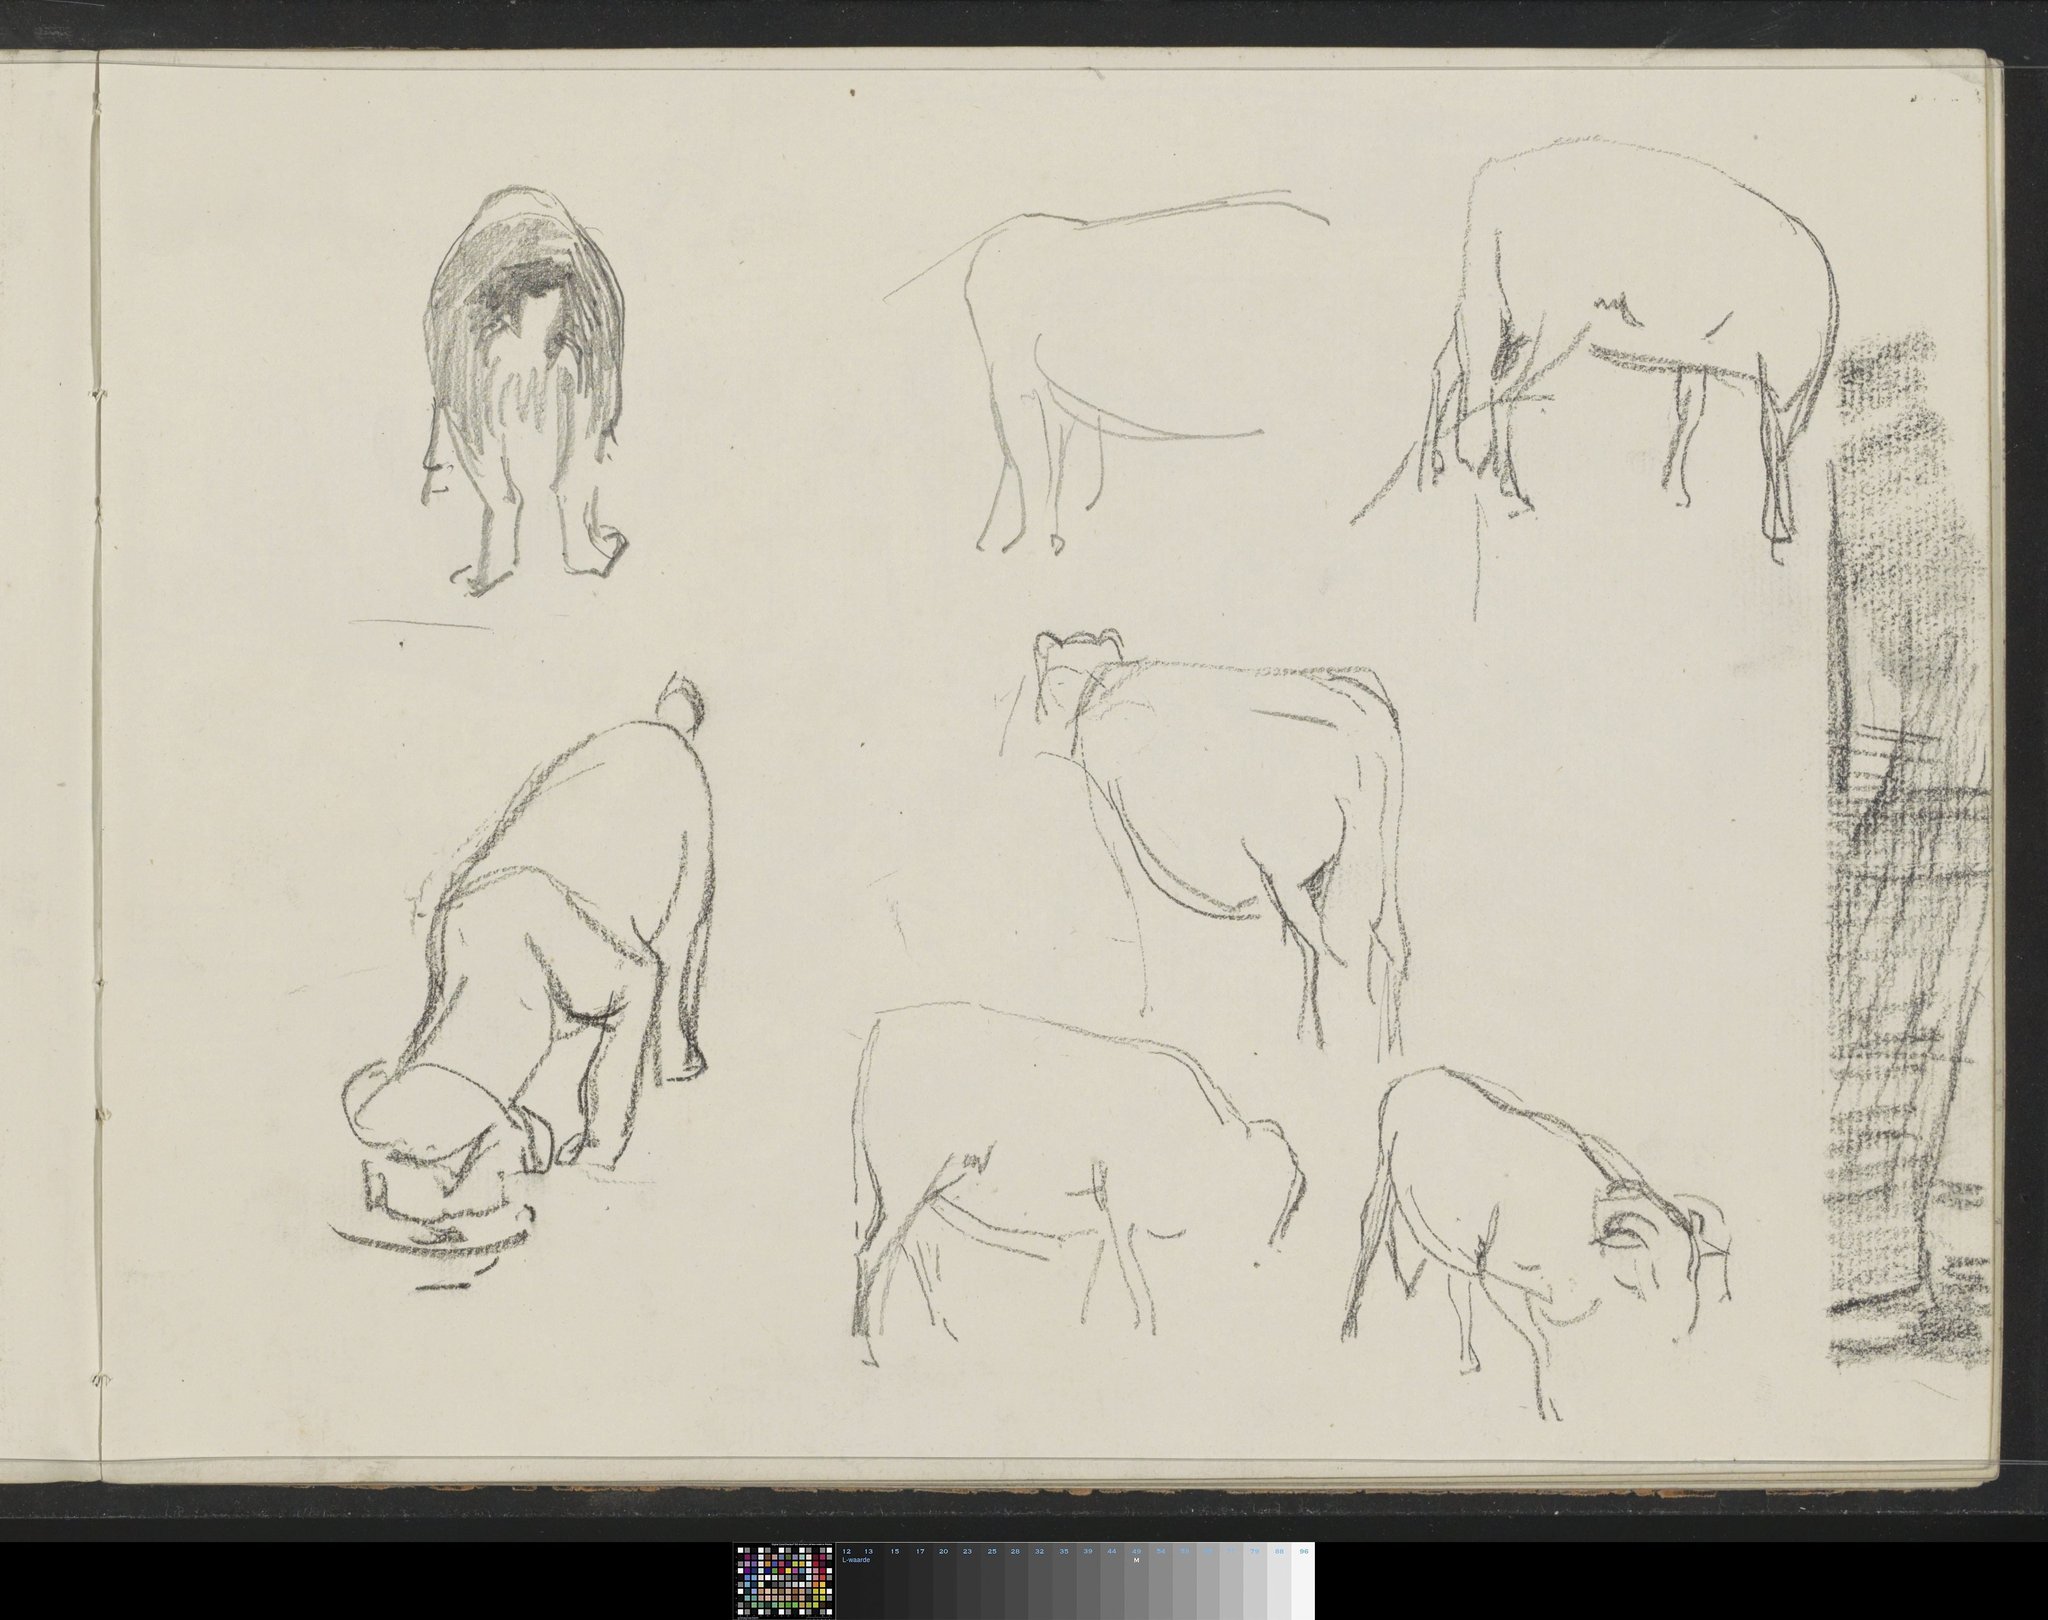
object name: sketchbook leaf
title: Studieblad met schapen en een hond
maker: ferdinand oldewelt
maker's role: draughtsman, print maker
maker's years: 1857-1935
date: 1904-1912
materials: chalk, paper, pencil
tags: sheep, dog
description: Blad 4 recto uit een schetsboek met 27 bladen.